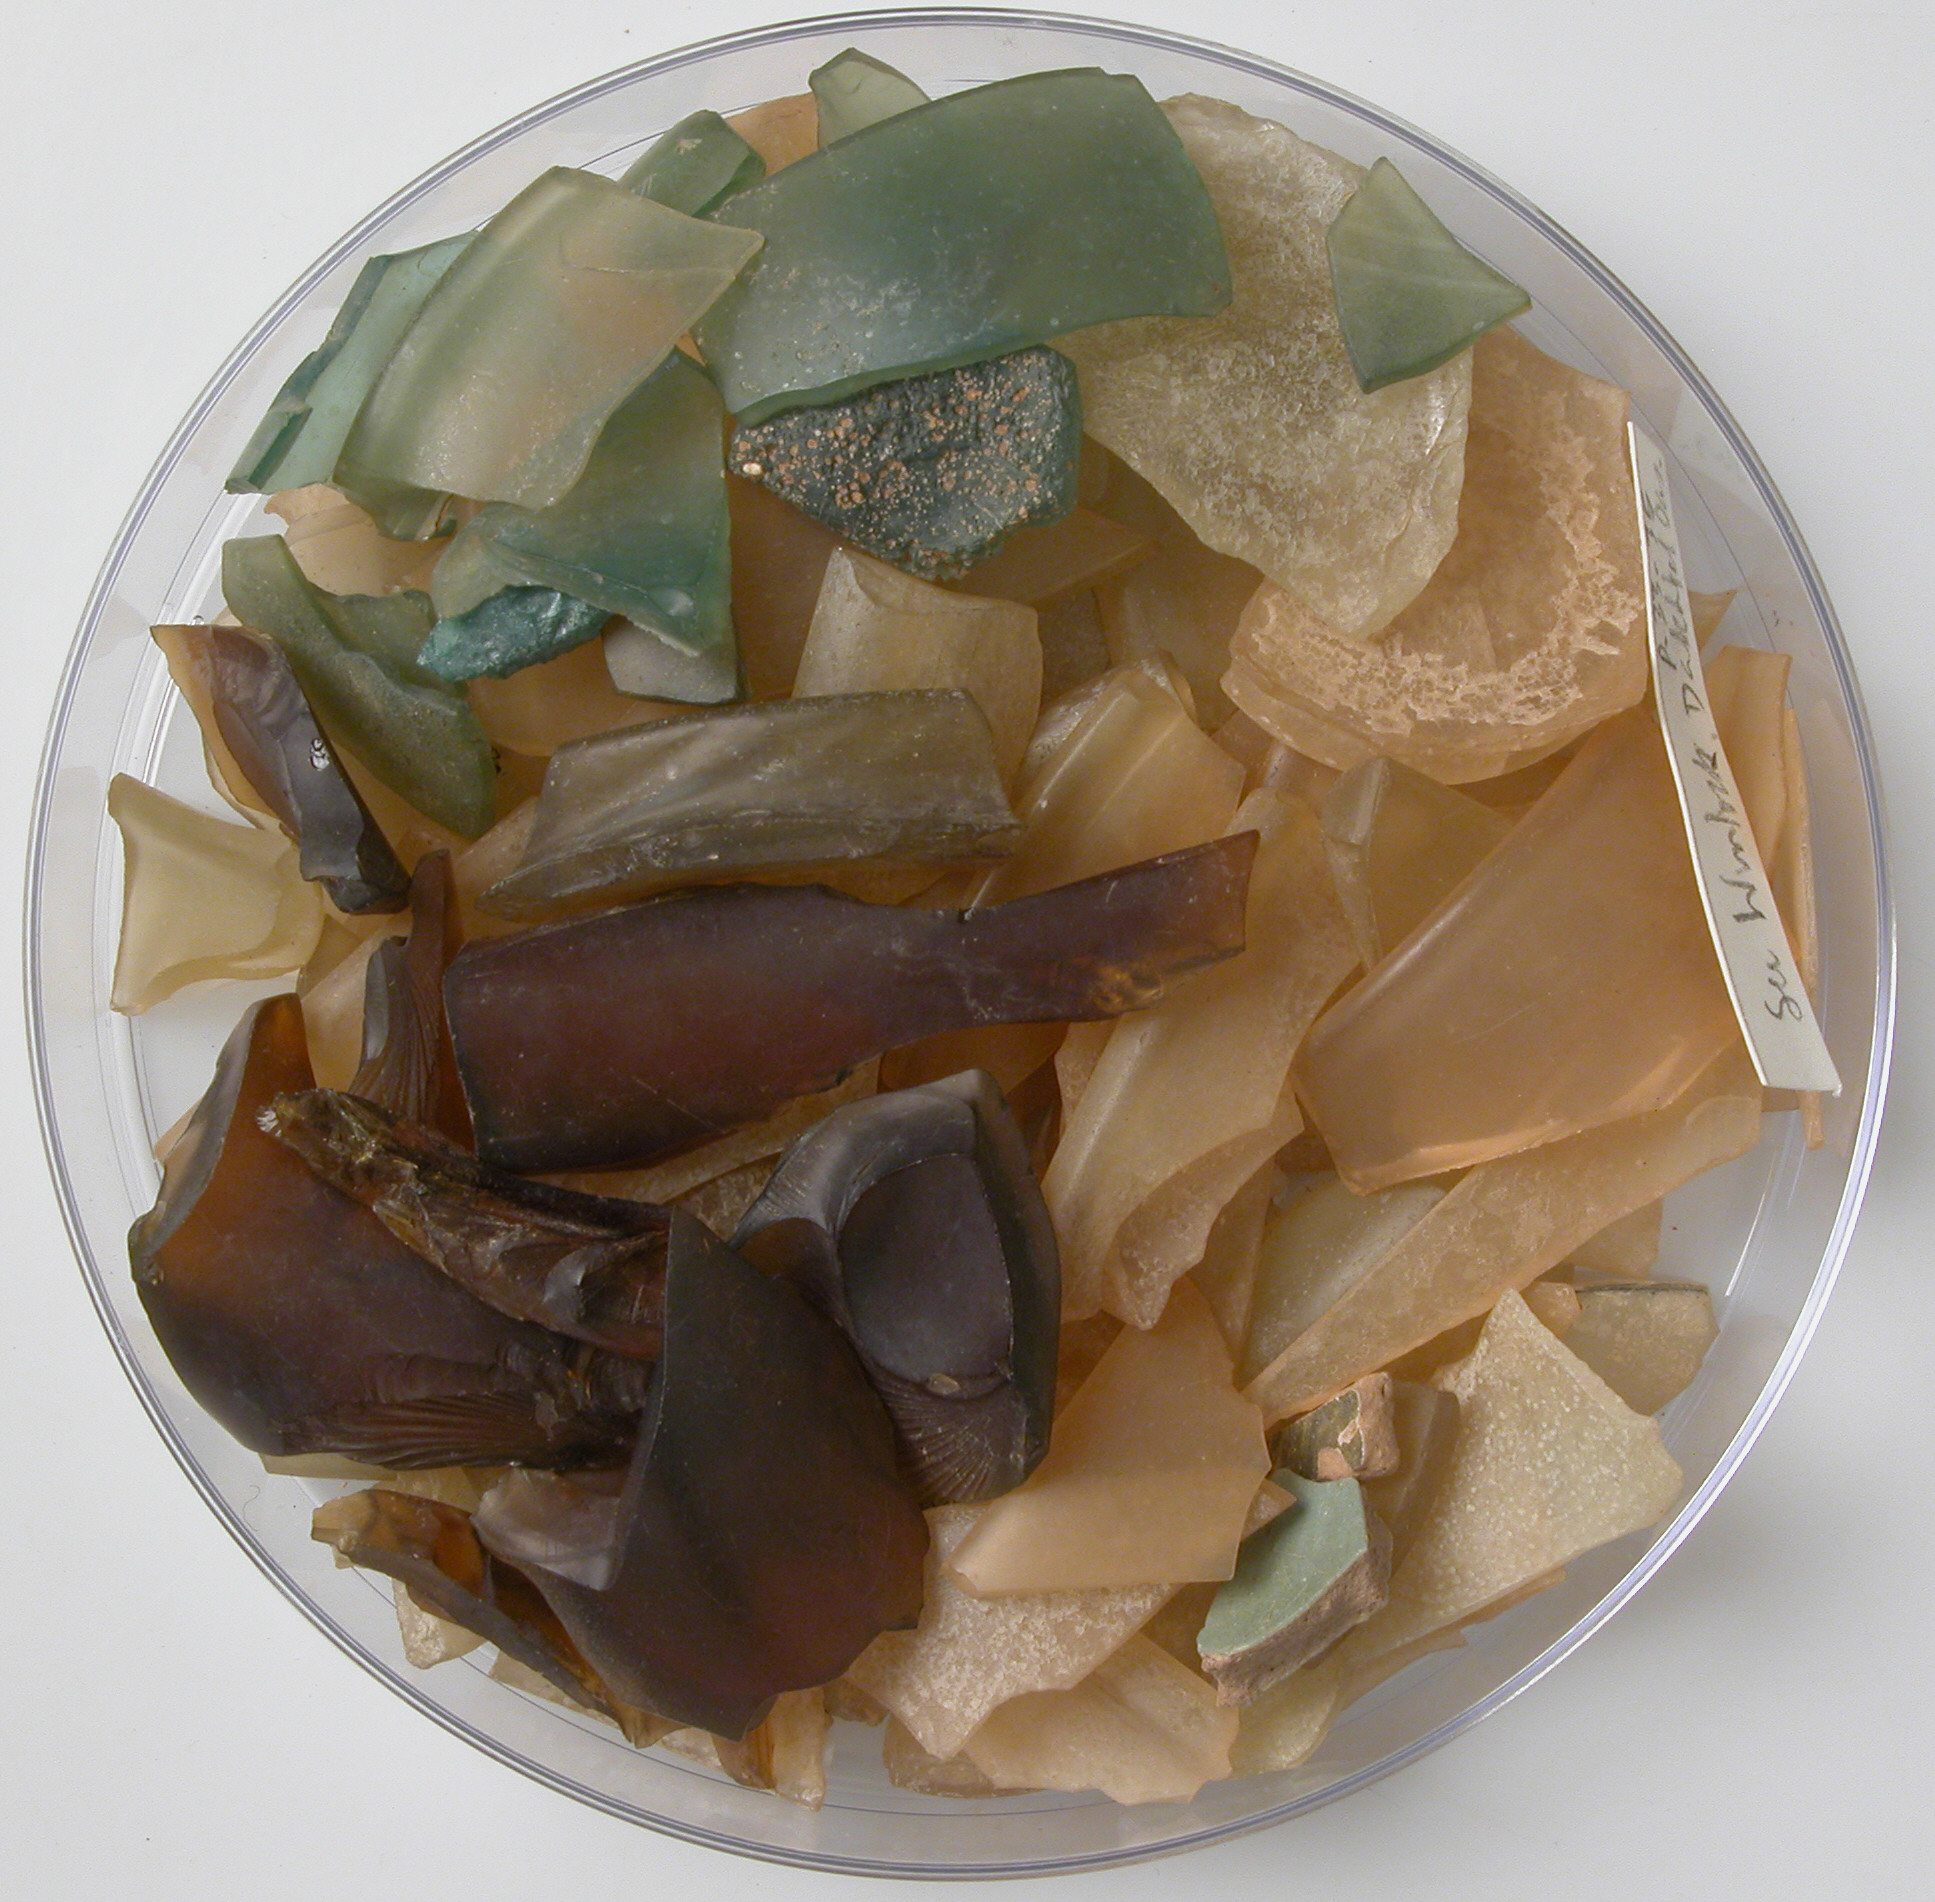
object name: fragment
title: Glass Fragments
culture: coptic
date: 301-700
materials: glass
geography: egypt